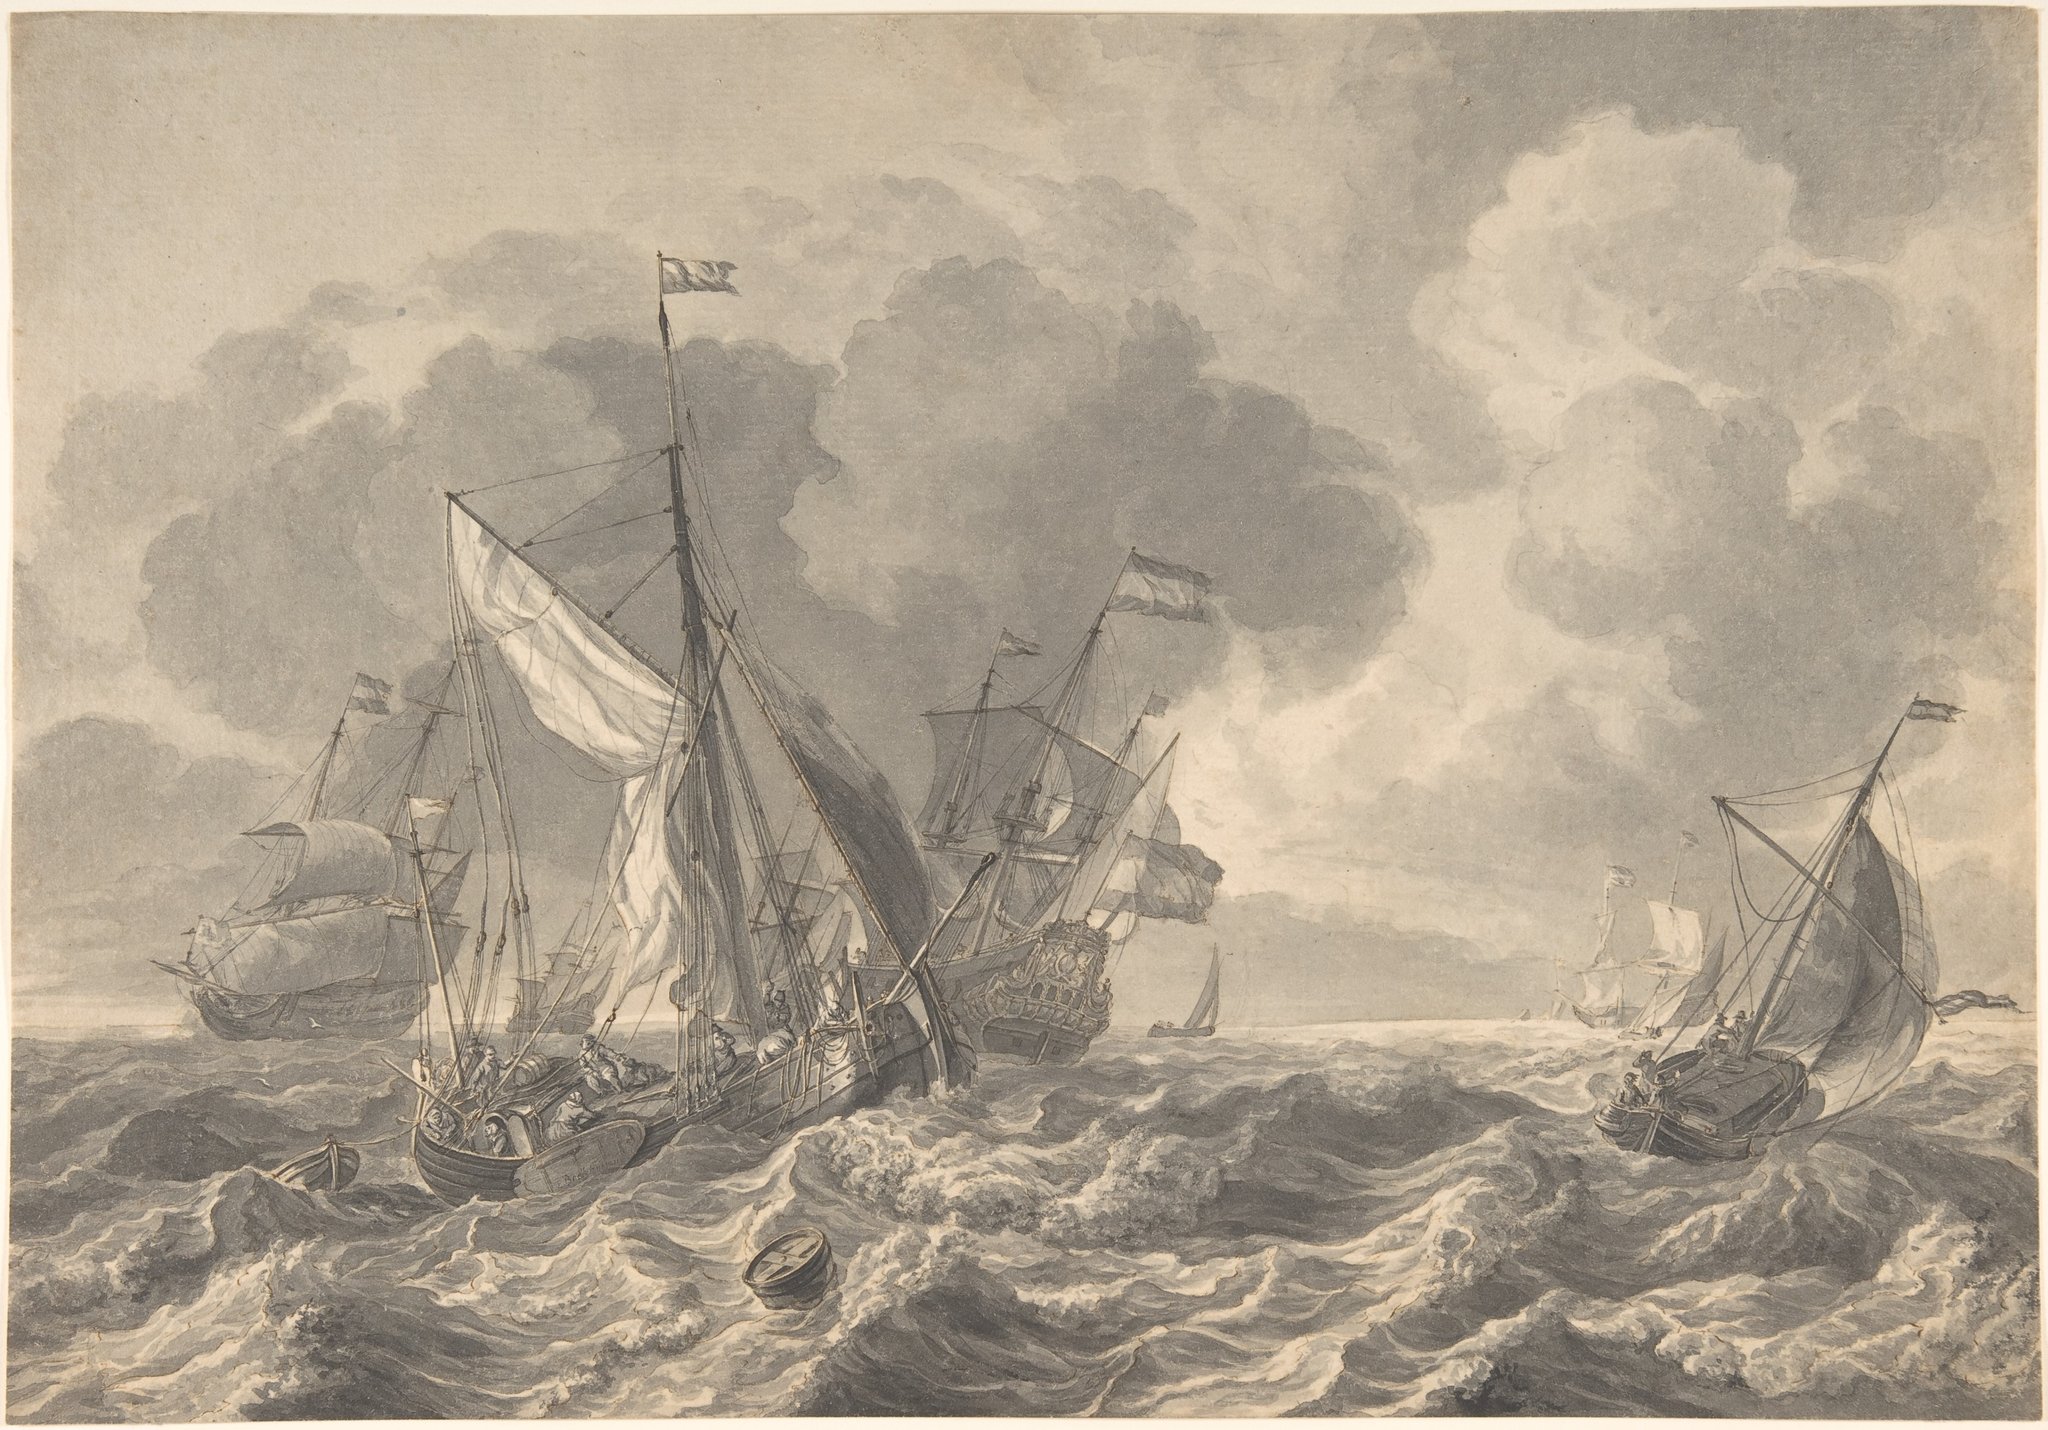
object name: drawing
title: Ships in a Stormy Sea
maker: ludolf backhuysen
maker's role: artist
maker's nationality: dutch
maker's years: 1630-1708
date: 1634-1733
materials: chalk, ink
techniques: pen, wash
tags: waves,storms,ships